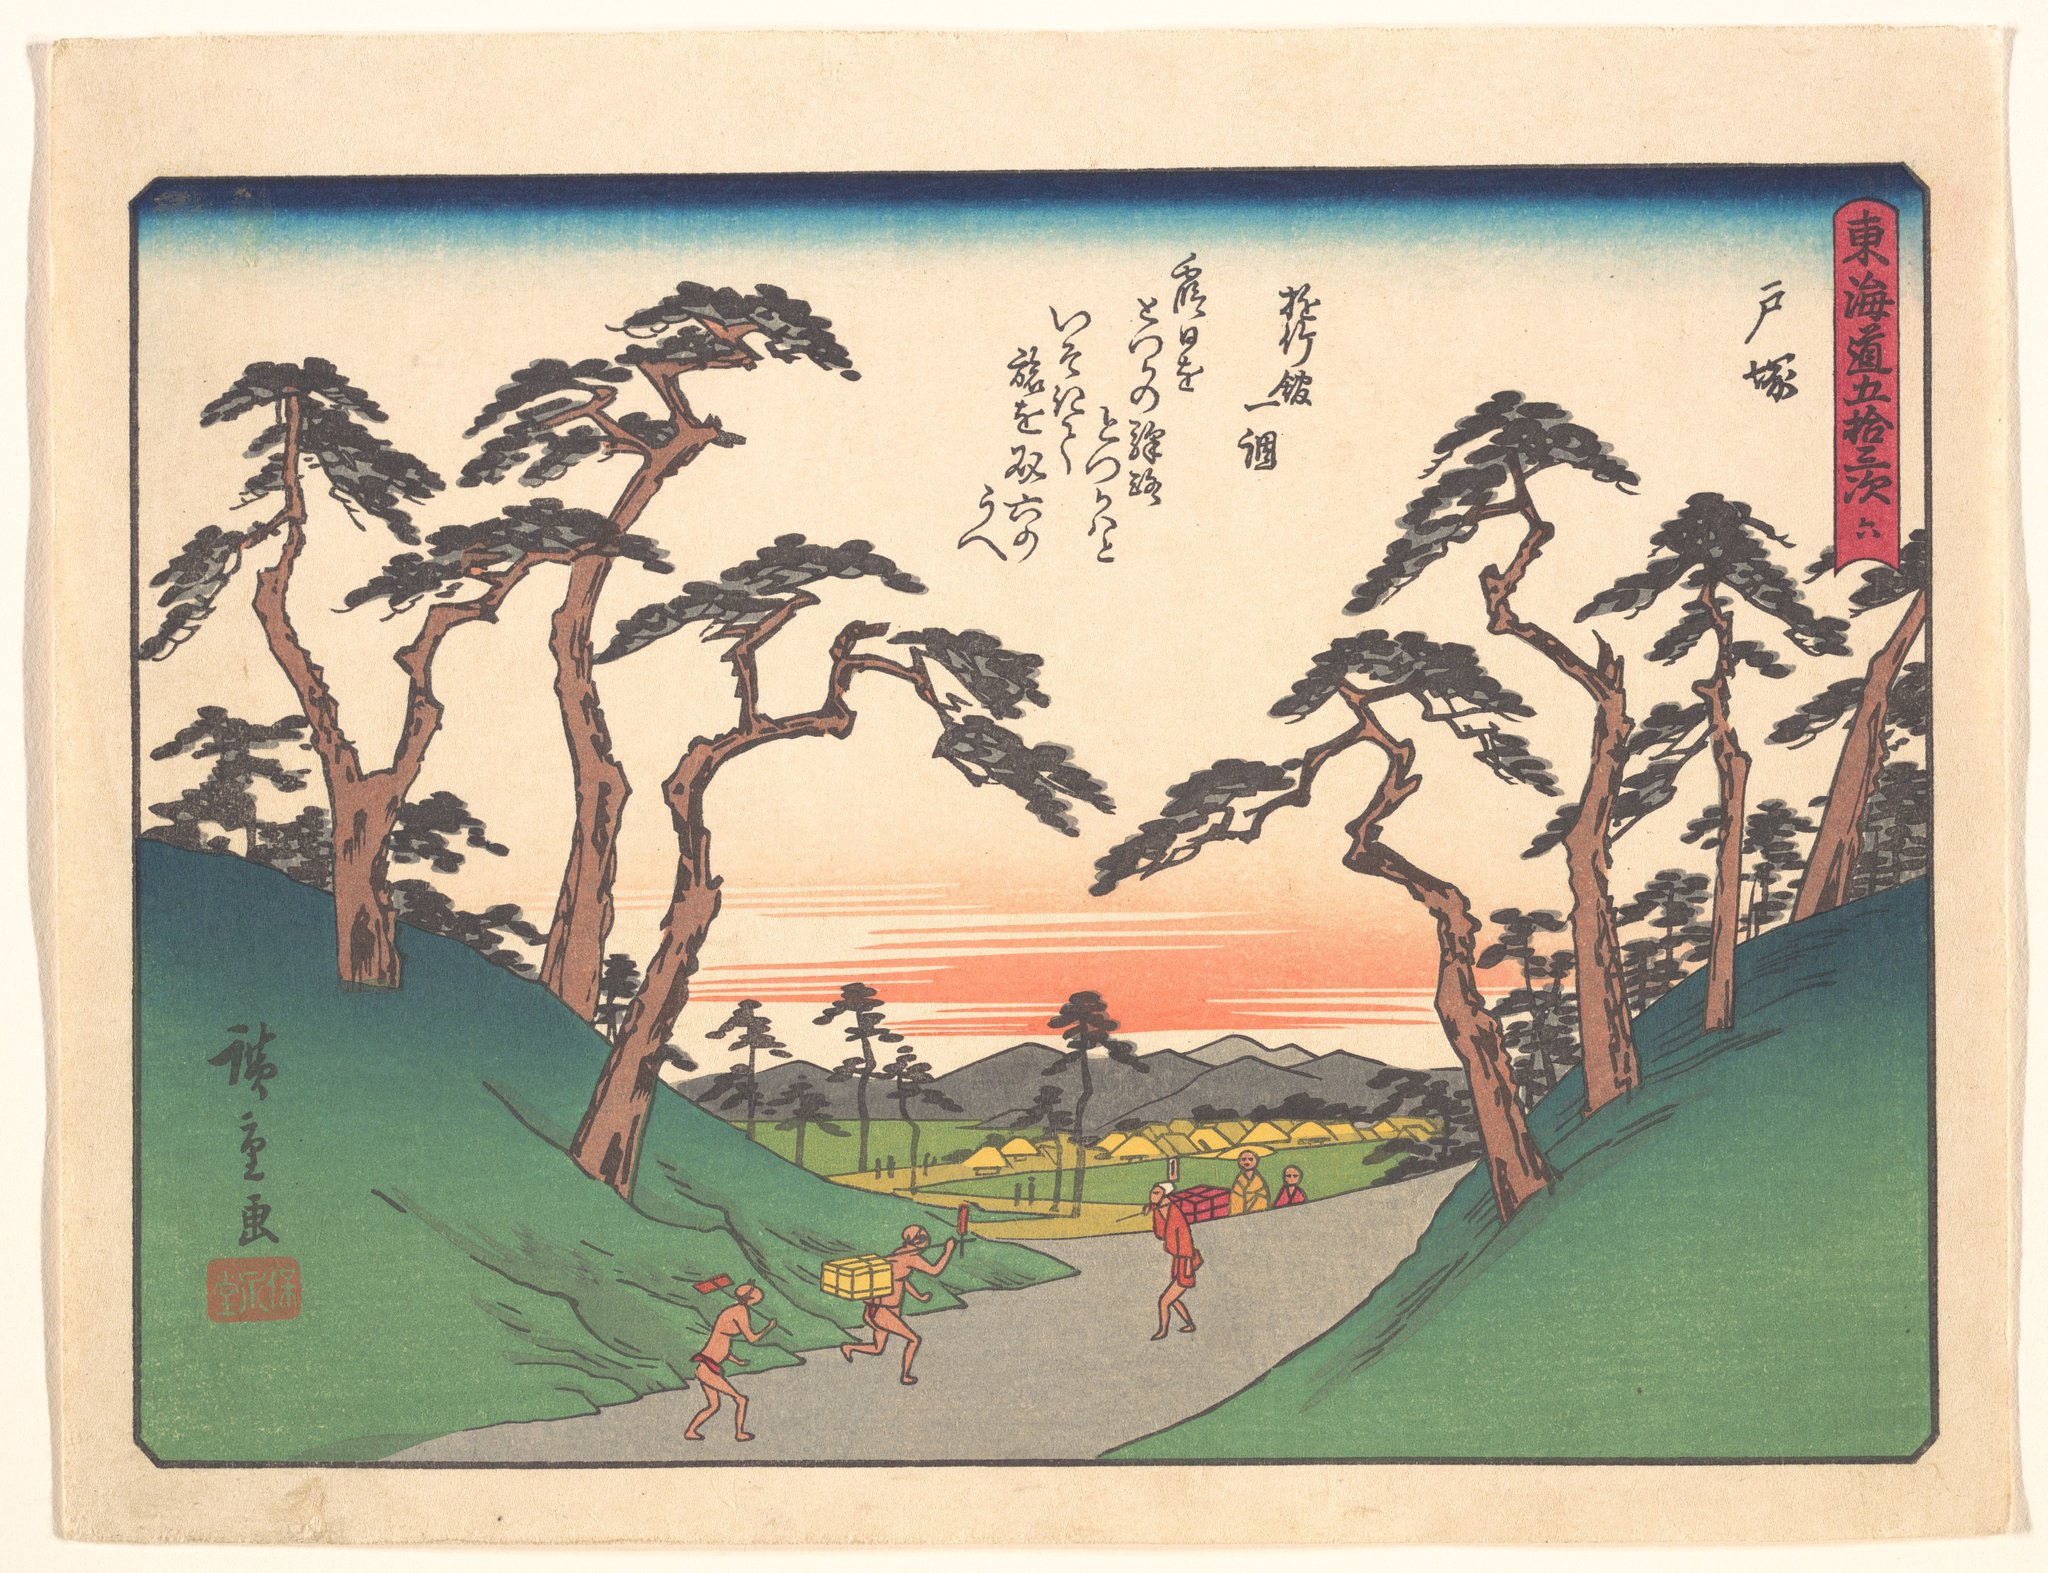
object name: print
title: 東海道五十三次 戸塚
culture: japanese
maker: utagawa hiroshige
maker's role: artist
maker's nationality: japanese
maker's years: 1797-1858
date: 1901-1933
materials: ink, paper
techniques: woodblock print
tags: roads,men,mountains,trees